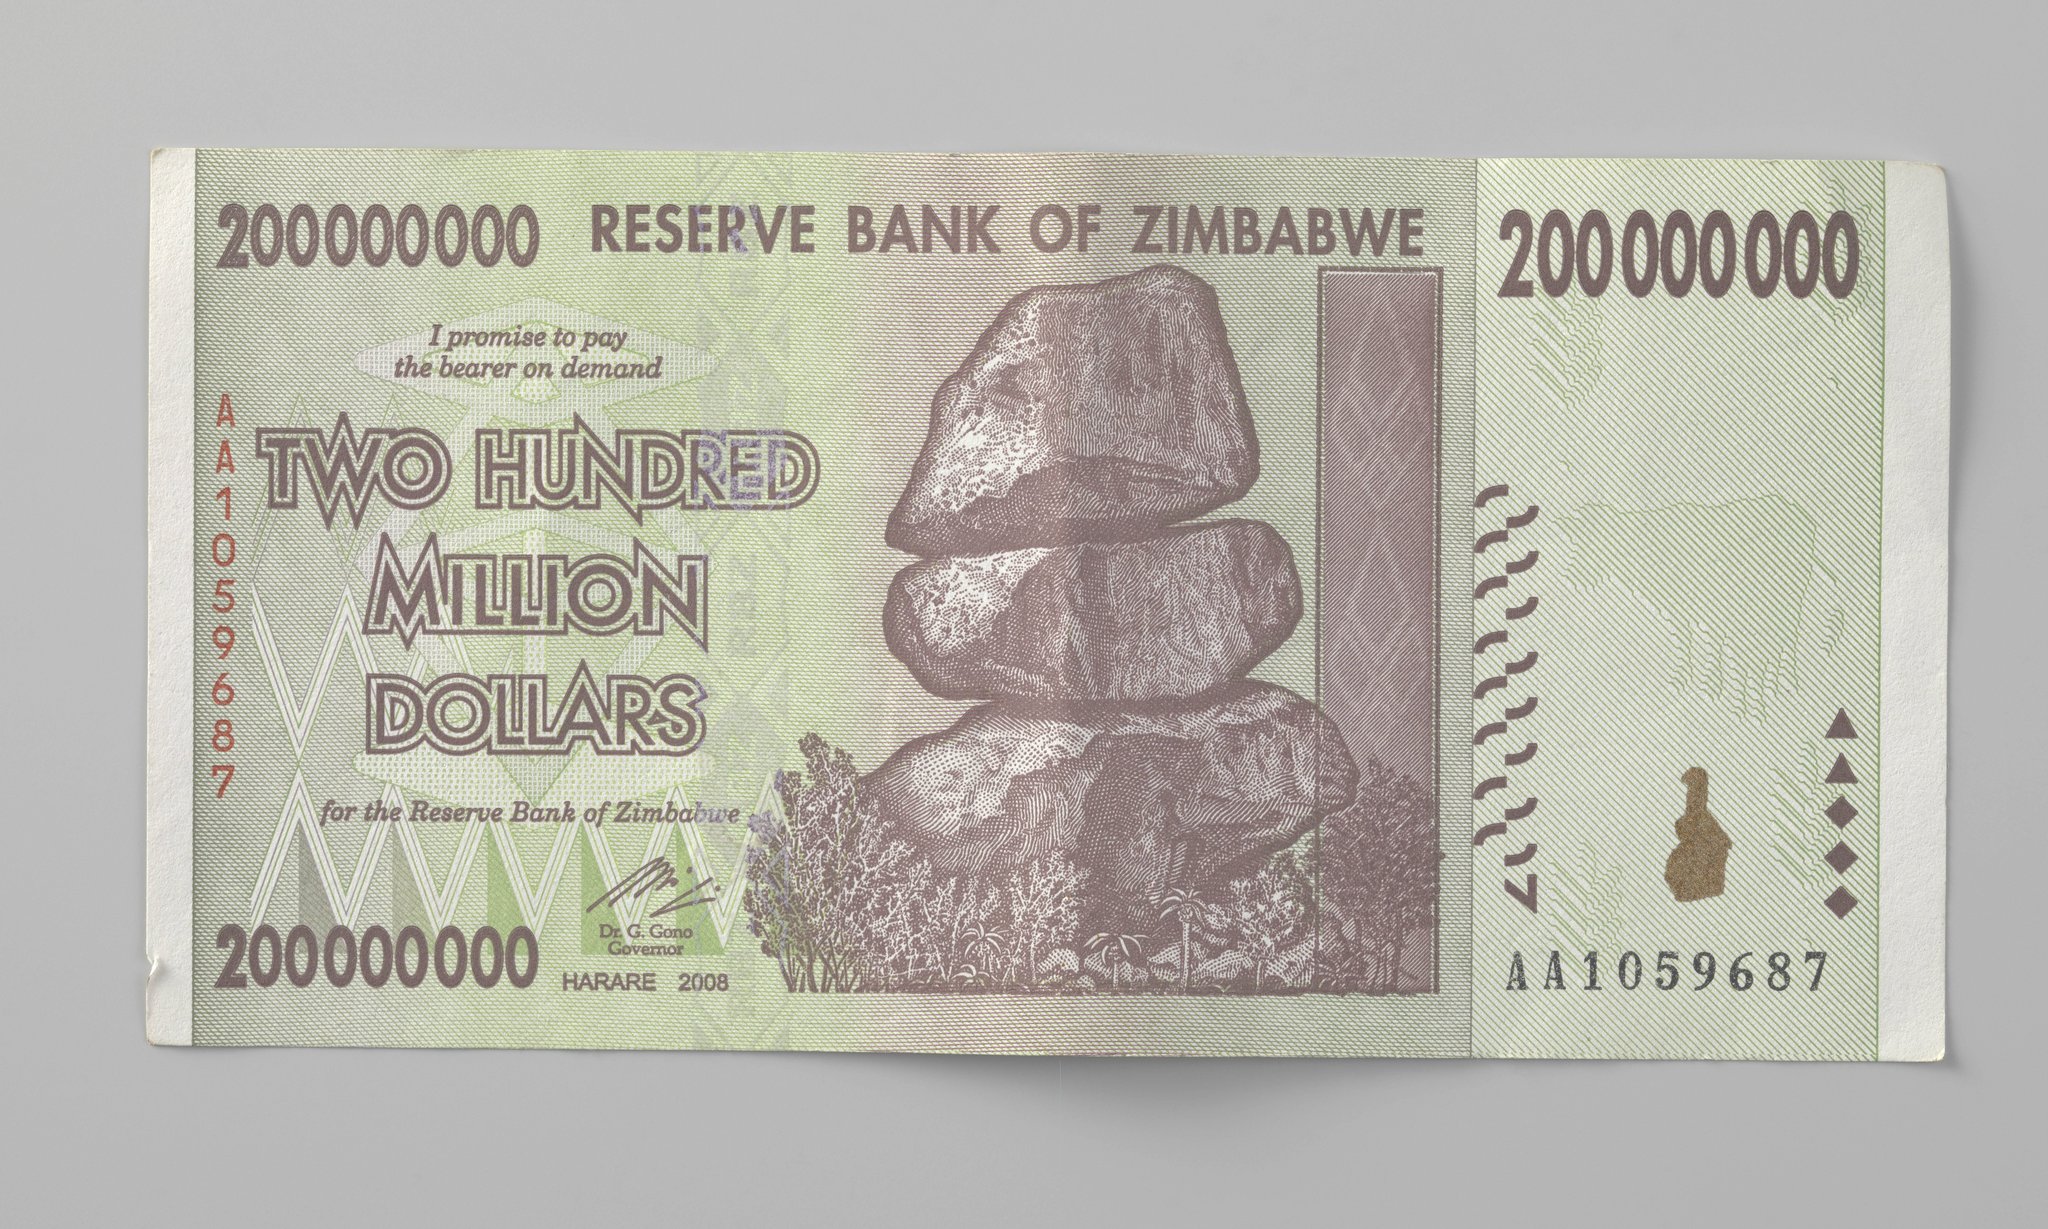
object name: tweehonderd miljoen dollar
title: Bankbiljet van tweehonderd miljoen Zimbabwaanse dollars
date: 2008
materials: paper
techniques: printing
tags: zimbabwe